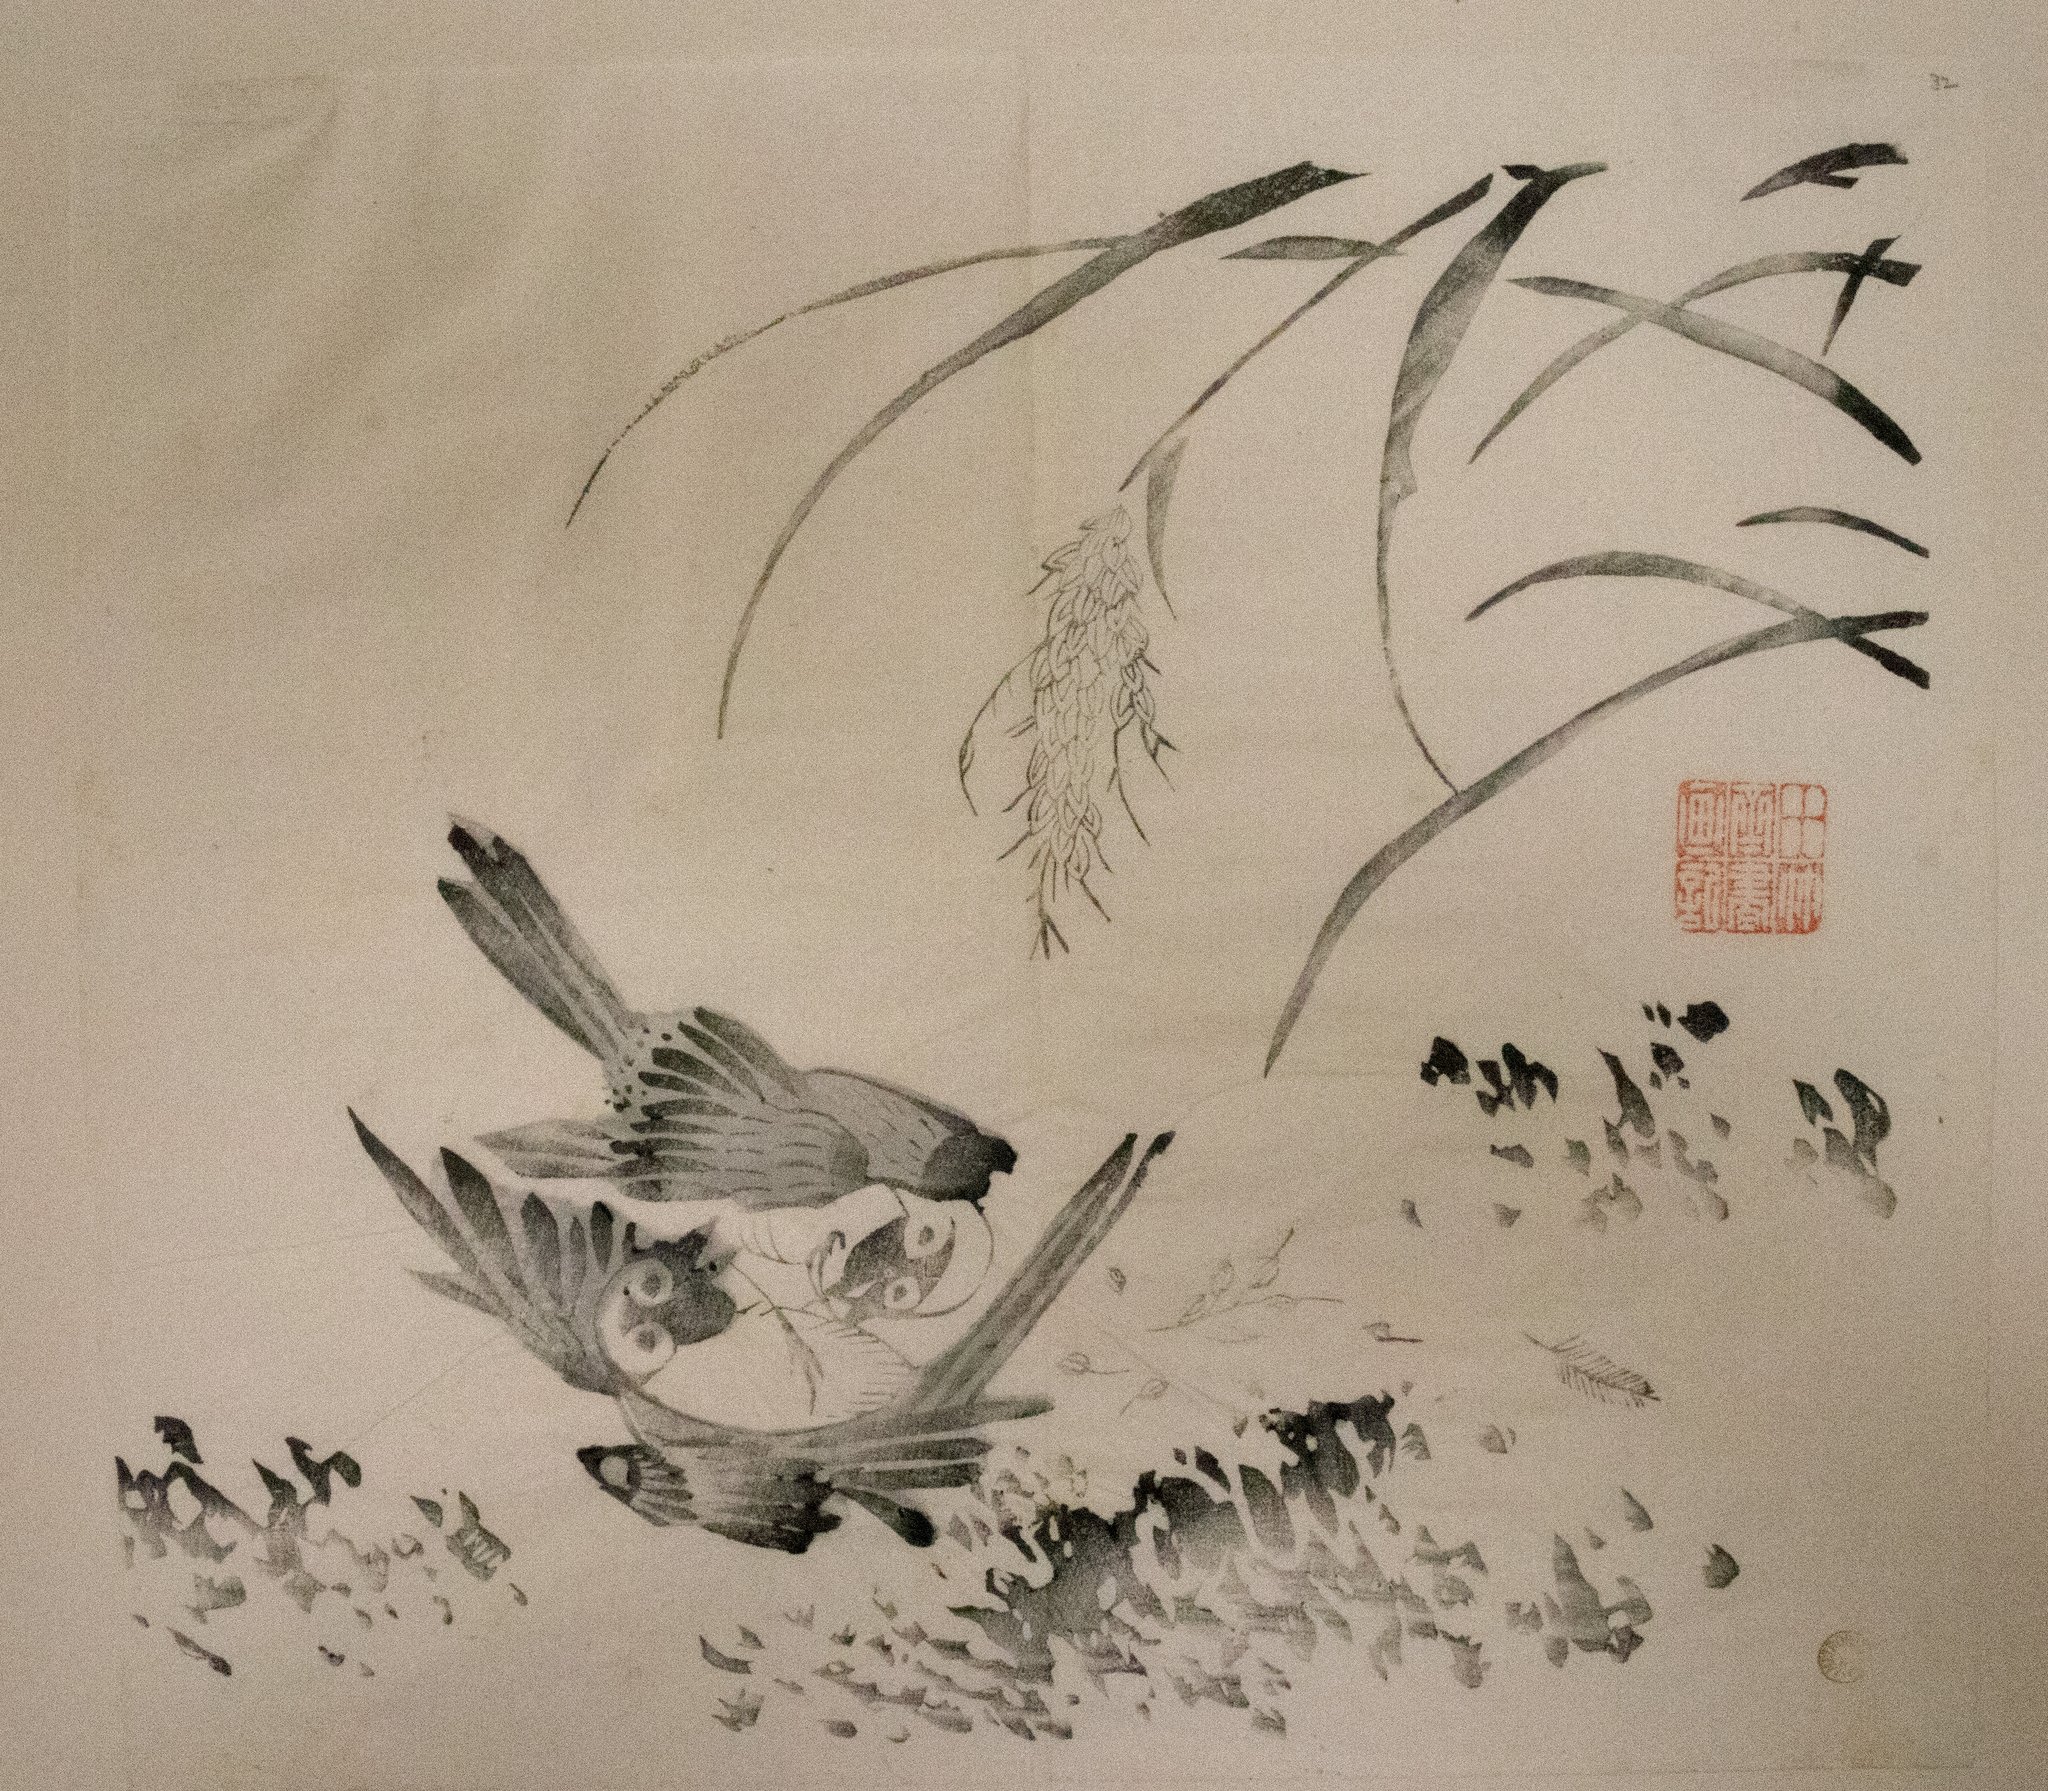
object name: print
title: Page from Shi Zhu Zhai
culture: chinese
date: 1736-1795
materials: ink, paper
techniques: polychrome, woodblock print